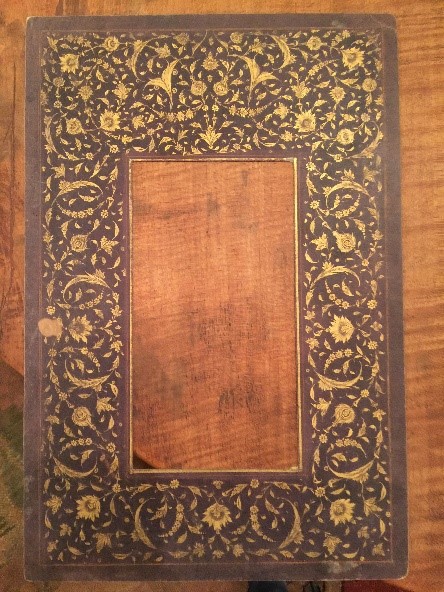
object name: folio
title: Decorated Folio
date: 1501-1900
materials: gold, ink, paper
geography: iran